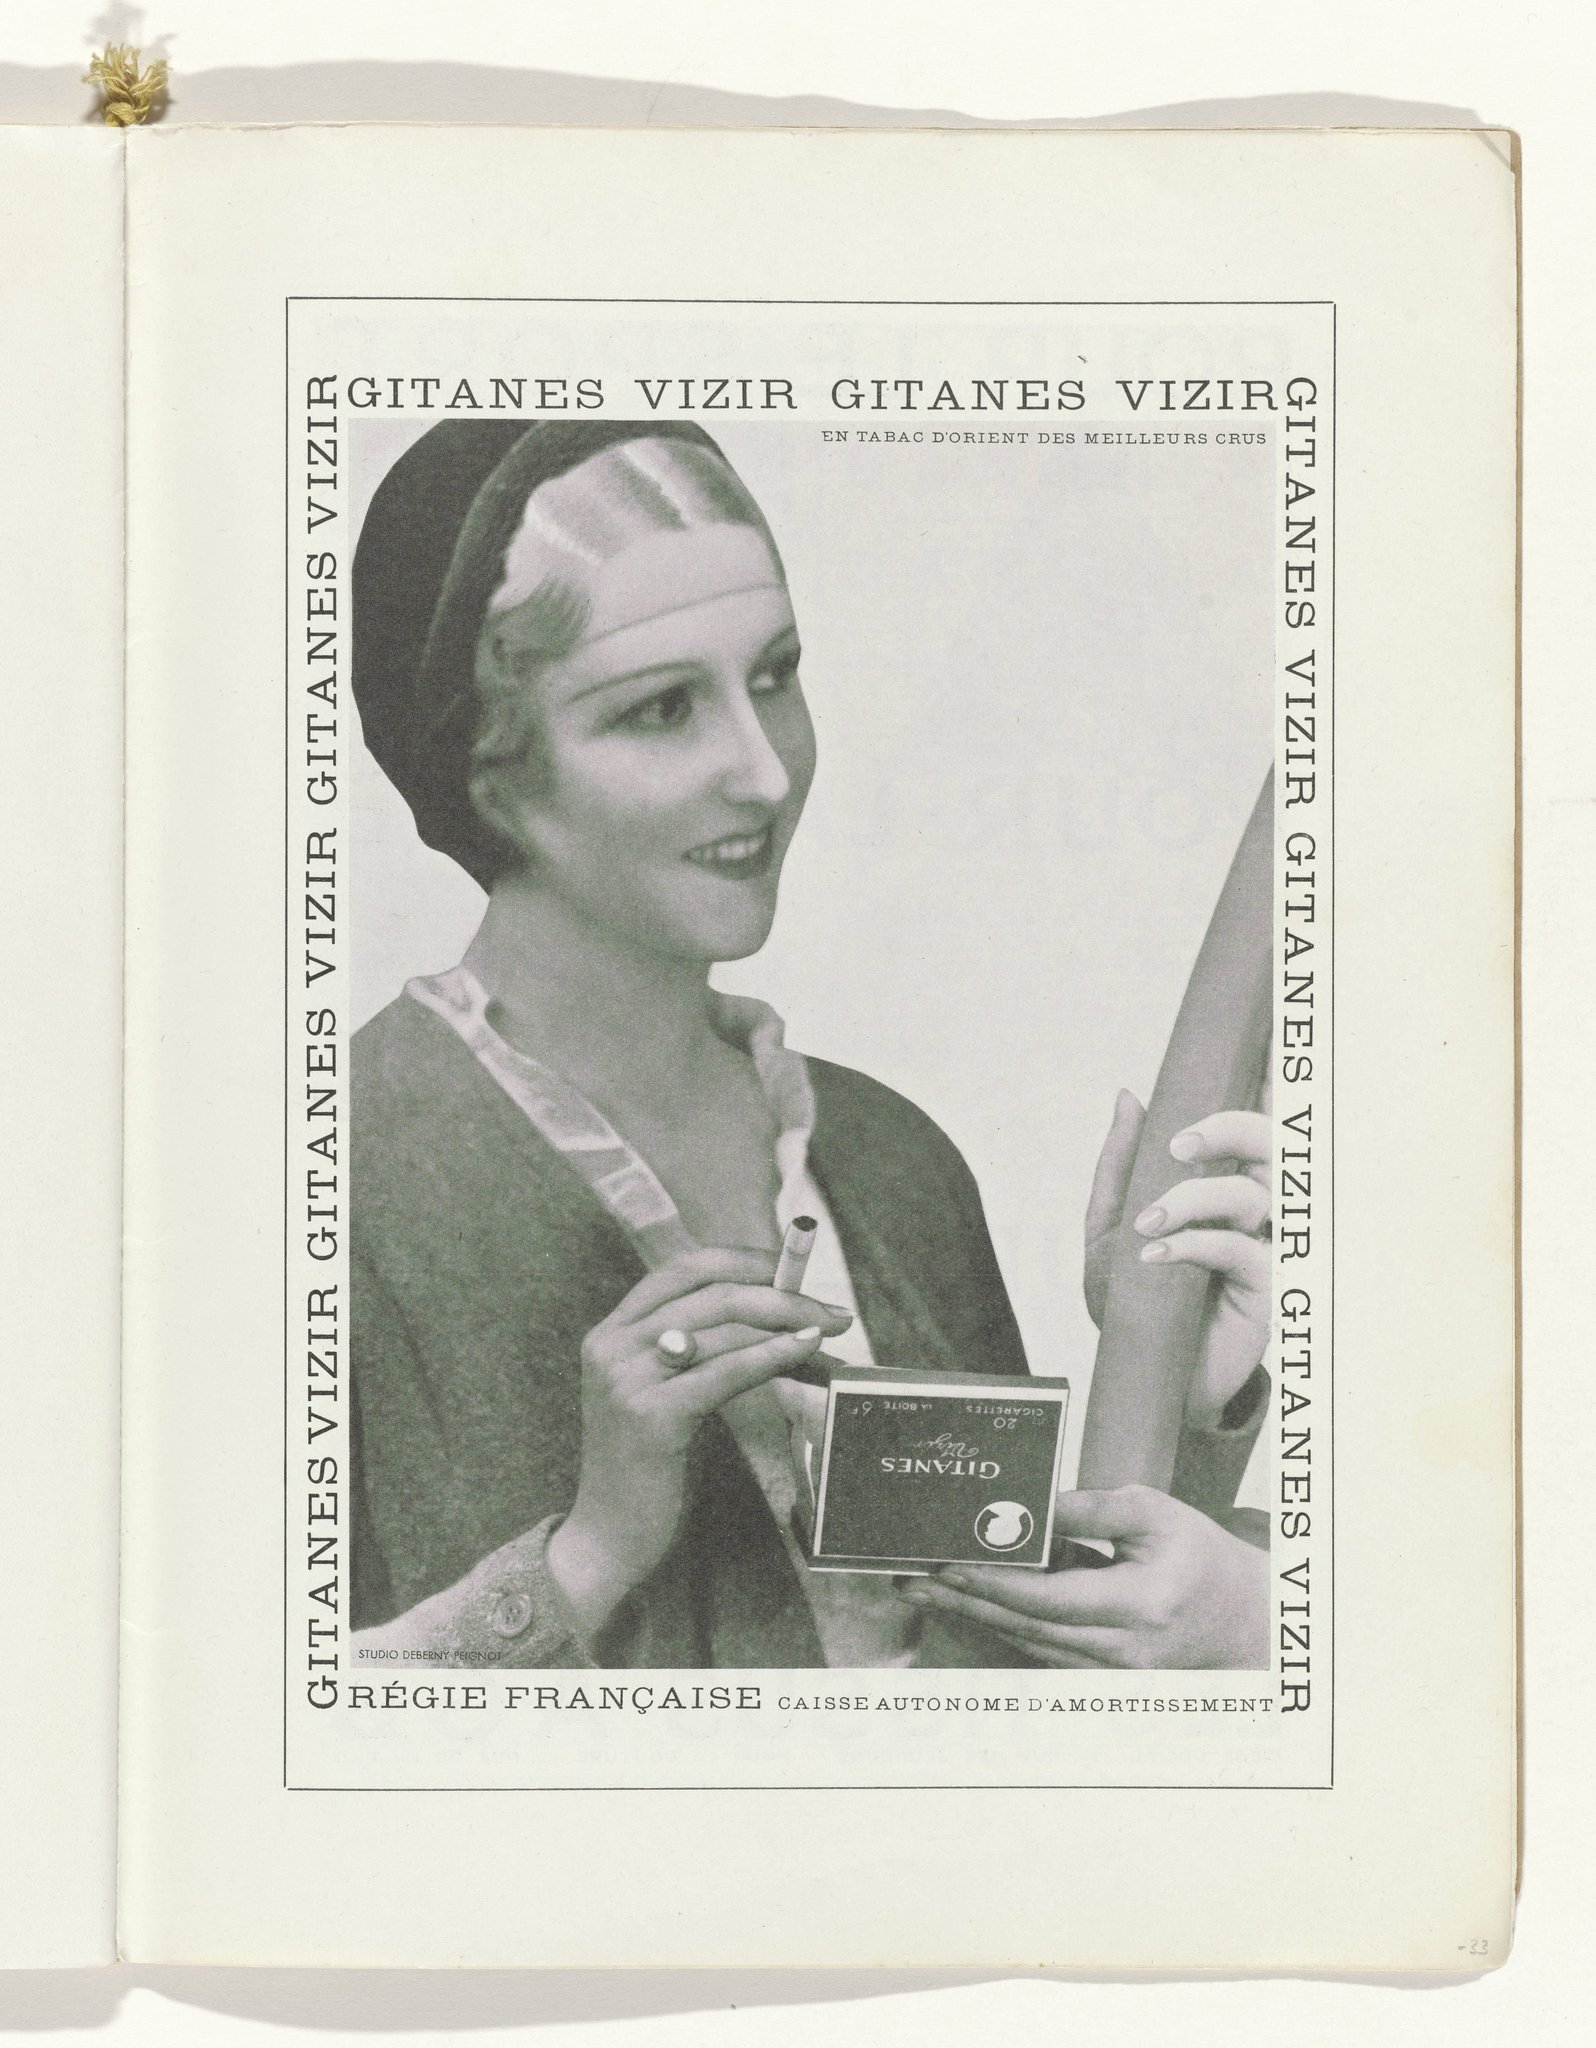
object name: fashion print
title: Art - Goût - Beauté, Feuillets de l' élégance féminine, Mars 1932, No. 139, 12e Année, p. 33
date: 1932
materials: paper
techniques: photography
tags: cigarette-case, fashion plates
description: Advertentie voor sigaretten 'Gitanes Vizir'.Pagina uit het modetijdschrift Art-Goût-Beauté (1920-1933).